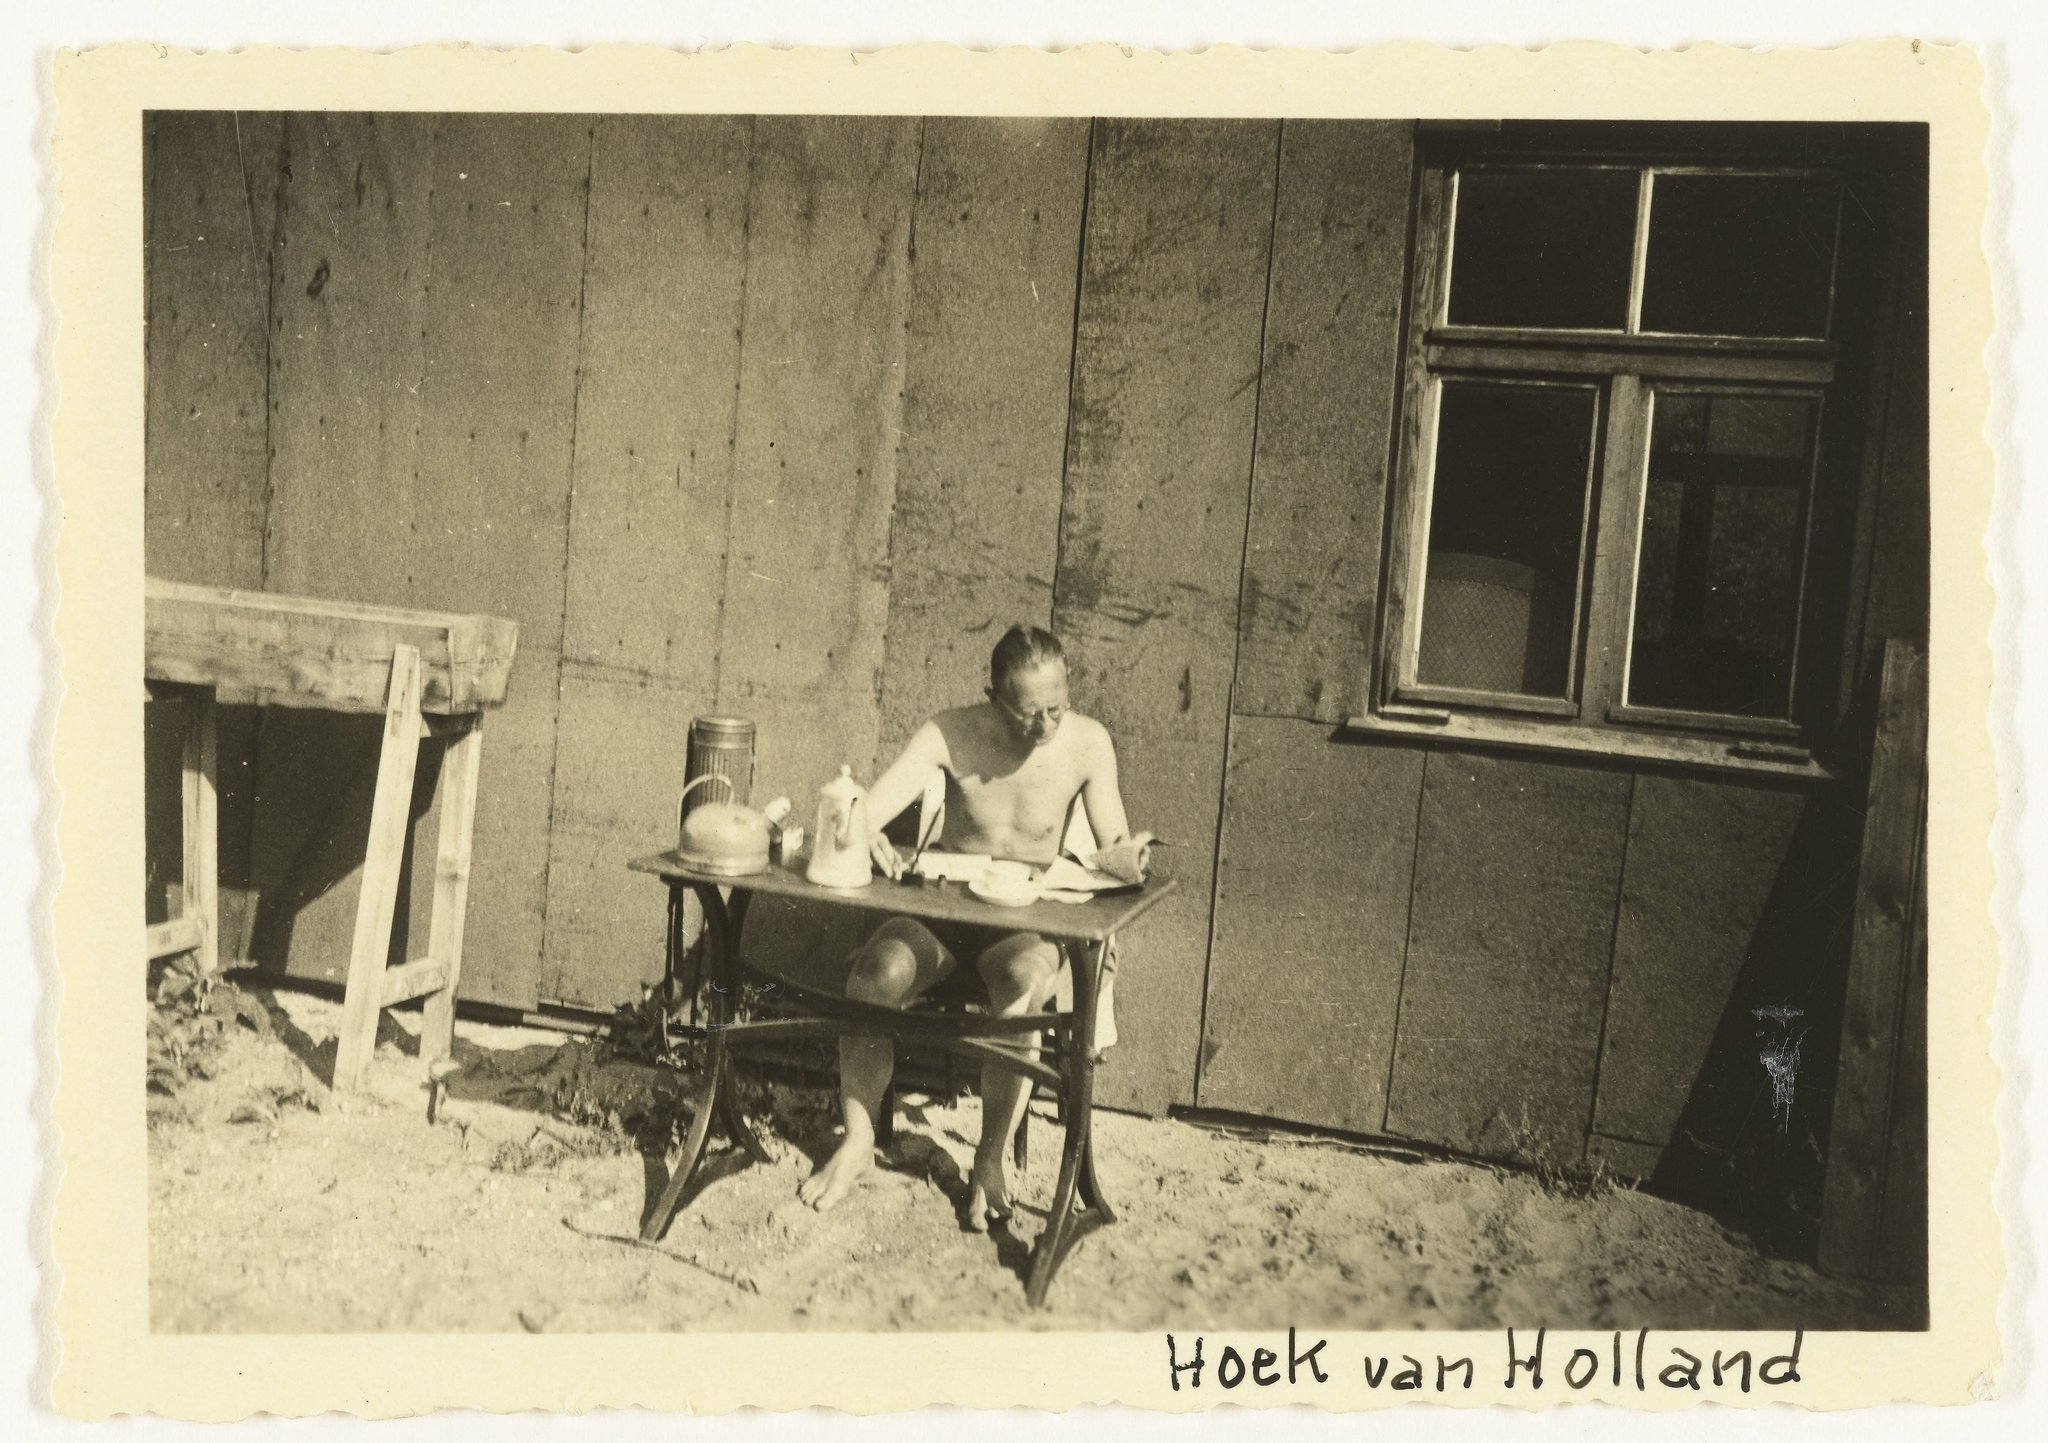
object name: photograph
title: Duitse soldaat aan het strand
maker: Anonymous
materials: photographic support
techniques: gelatin silver print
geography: hoek van holland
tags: beach (as place of recreation), occupier and civilians, occupation ~ war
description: Duitse soldaat zit voor een houten barak aan een tafeltje in de zon in Hoek van Holland. Bovenlijf ontbloot en blote voeten in het zand. Hij kijkt in een tijdschrift. Voor hem ligt papier en op tafel staan een kopje, een koffiepot, een fluitketel en iets wat lijkt op een thermoskan. Links van hem een hakblok om hout te hakken.